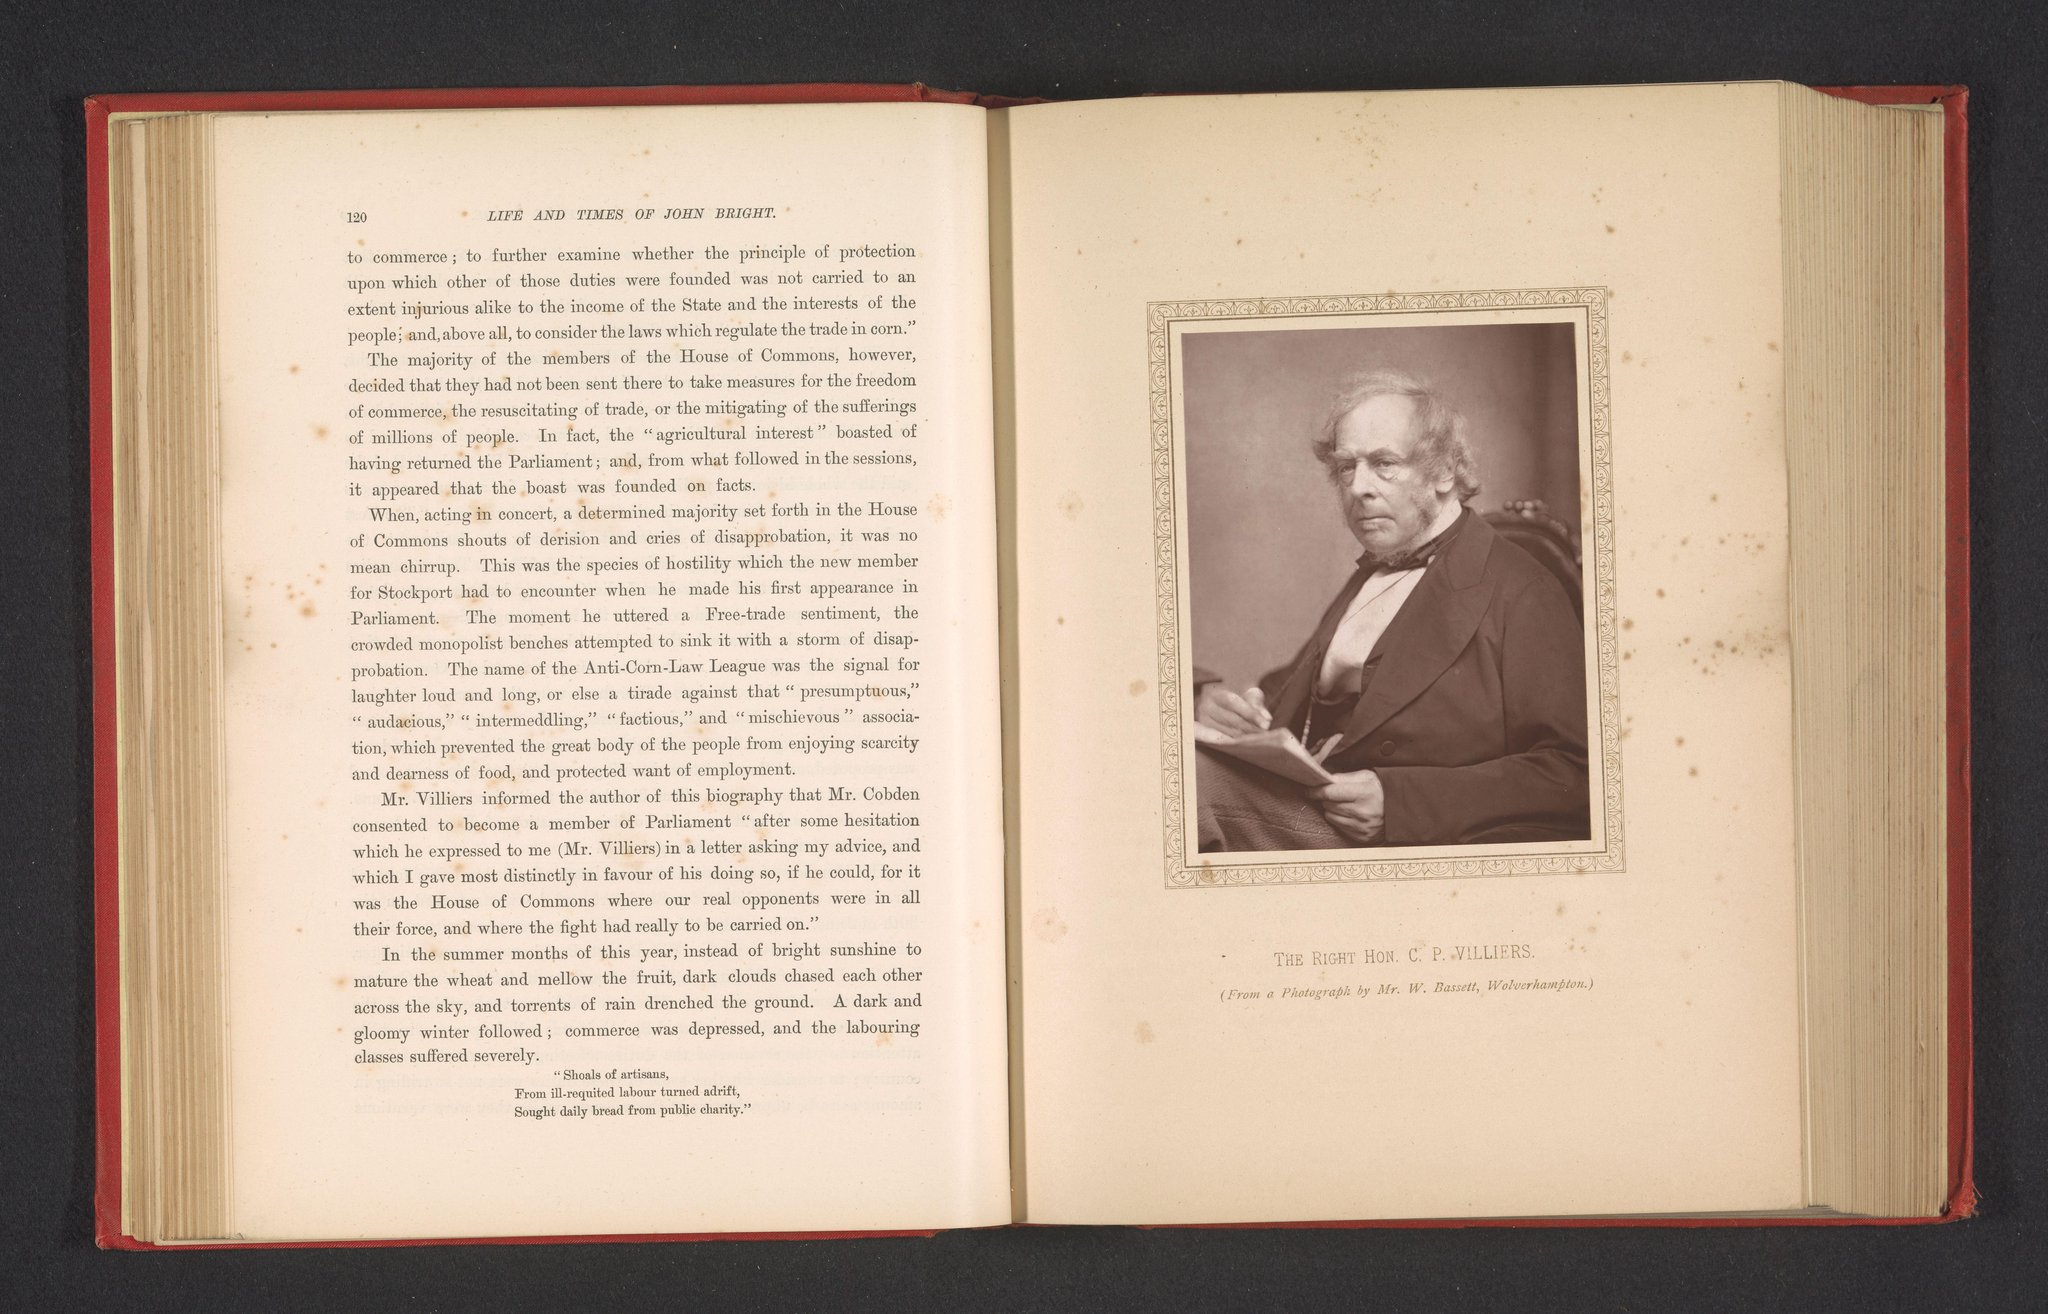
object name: page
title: The right hon. C.P. Villiers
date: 1874-1884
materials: paper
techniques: woodburytype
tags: politician, adult man, politician, e.g. party leader